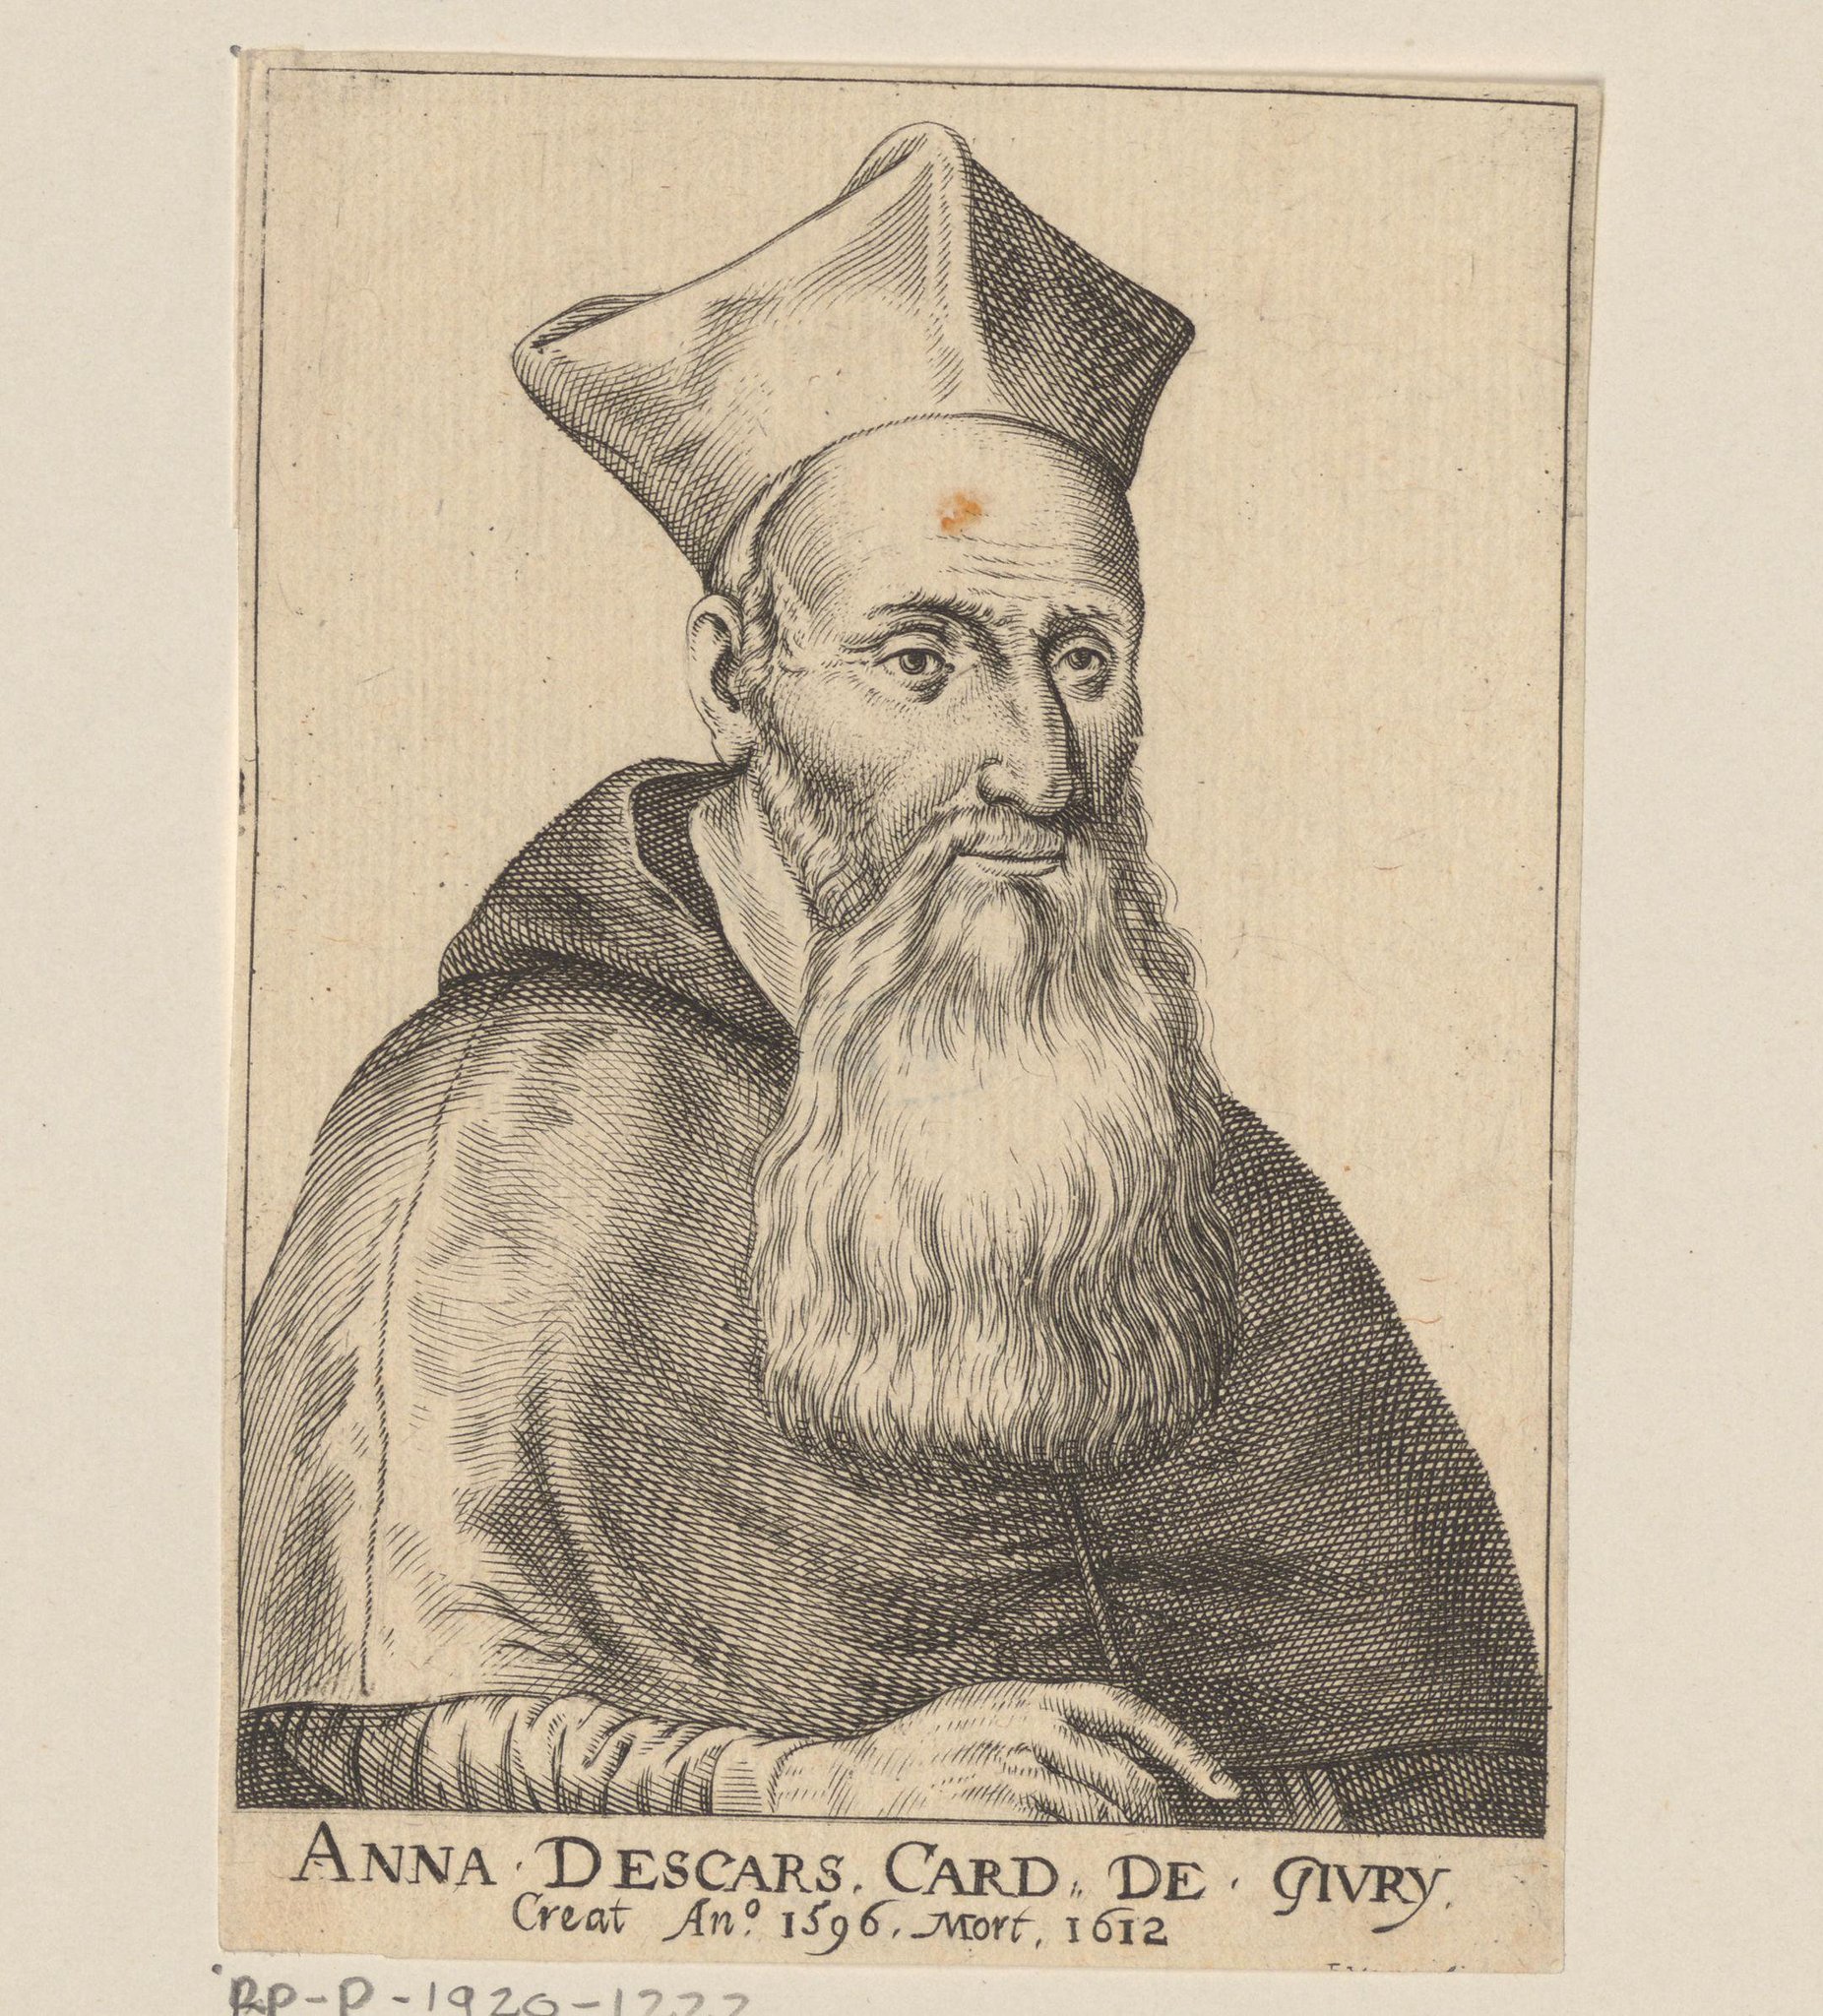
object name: print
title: Portret van Annas de Perusse-d'Escars de Givry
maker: frans van den wijngaerde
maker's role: print maker, publisher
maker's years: 1614-1679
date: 1644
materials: paper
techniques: engraving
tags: cardinal, historical persons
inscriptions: collector's mark: Lugt 2228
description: Prent met tekst op verso gebruikt in: Albi, Henri. Eloges historiques des cardinaux illustres François et etrangers mis en parallele. Parijs: Anthoine de Cay, 1644.